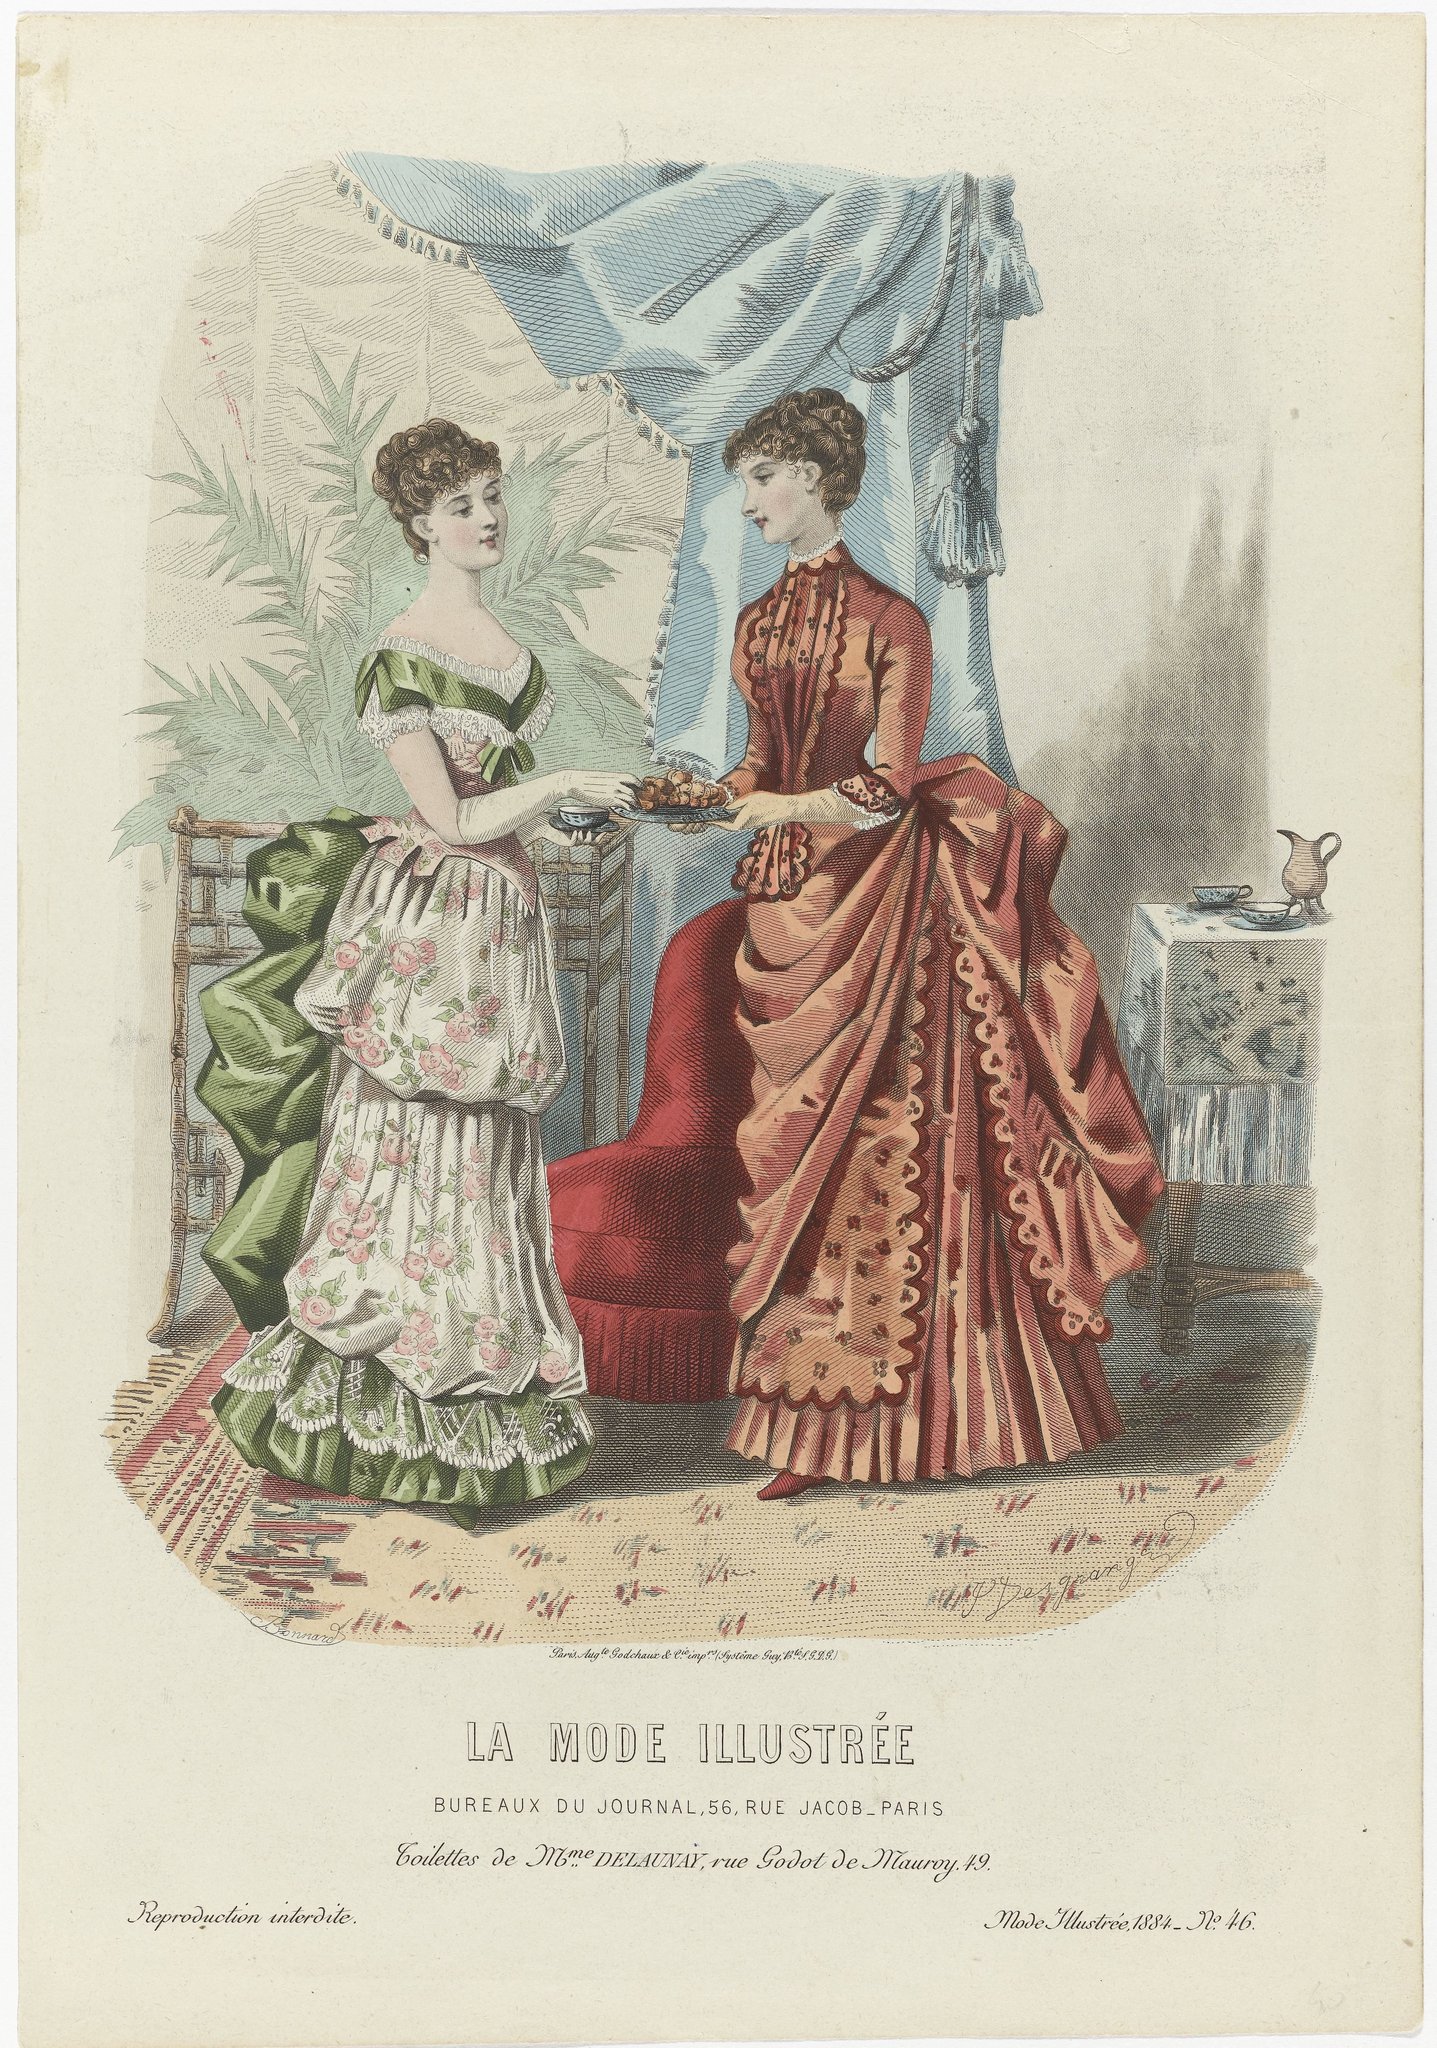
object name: fashion print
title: La Mode Illustrée, 1884, No. 46 : Toilettes de Mme Delaunay (...)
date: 1884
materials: paper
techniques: engraving, hand coloring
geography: paris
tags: curtains, giving food, fashion plates, clothes, costume (+ women's clothes), gloves, mittens, etc. (+ women's clothes), dress, gown (+ women's clothes), cup and saucer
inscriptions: title: ‘La Mode Illustrée’, caption: ‘Toilettes de M.me Delaunauy, rue Godot de Mauroy, 49.’, address: ‘Bureaux du journal, 56, rue Jacob. Paris’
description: Twee vrouwen in interieur, gekleed in japonnen met tournure. Volgens het onderschrift: ensembles van Delaunay. Prent uit het modetijdschrift La Mode Illustrée (1860-1937).